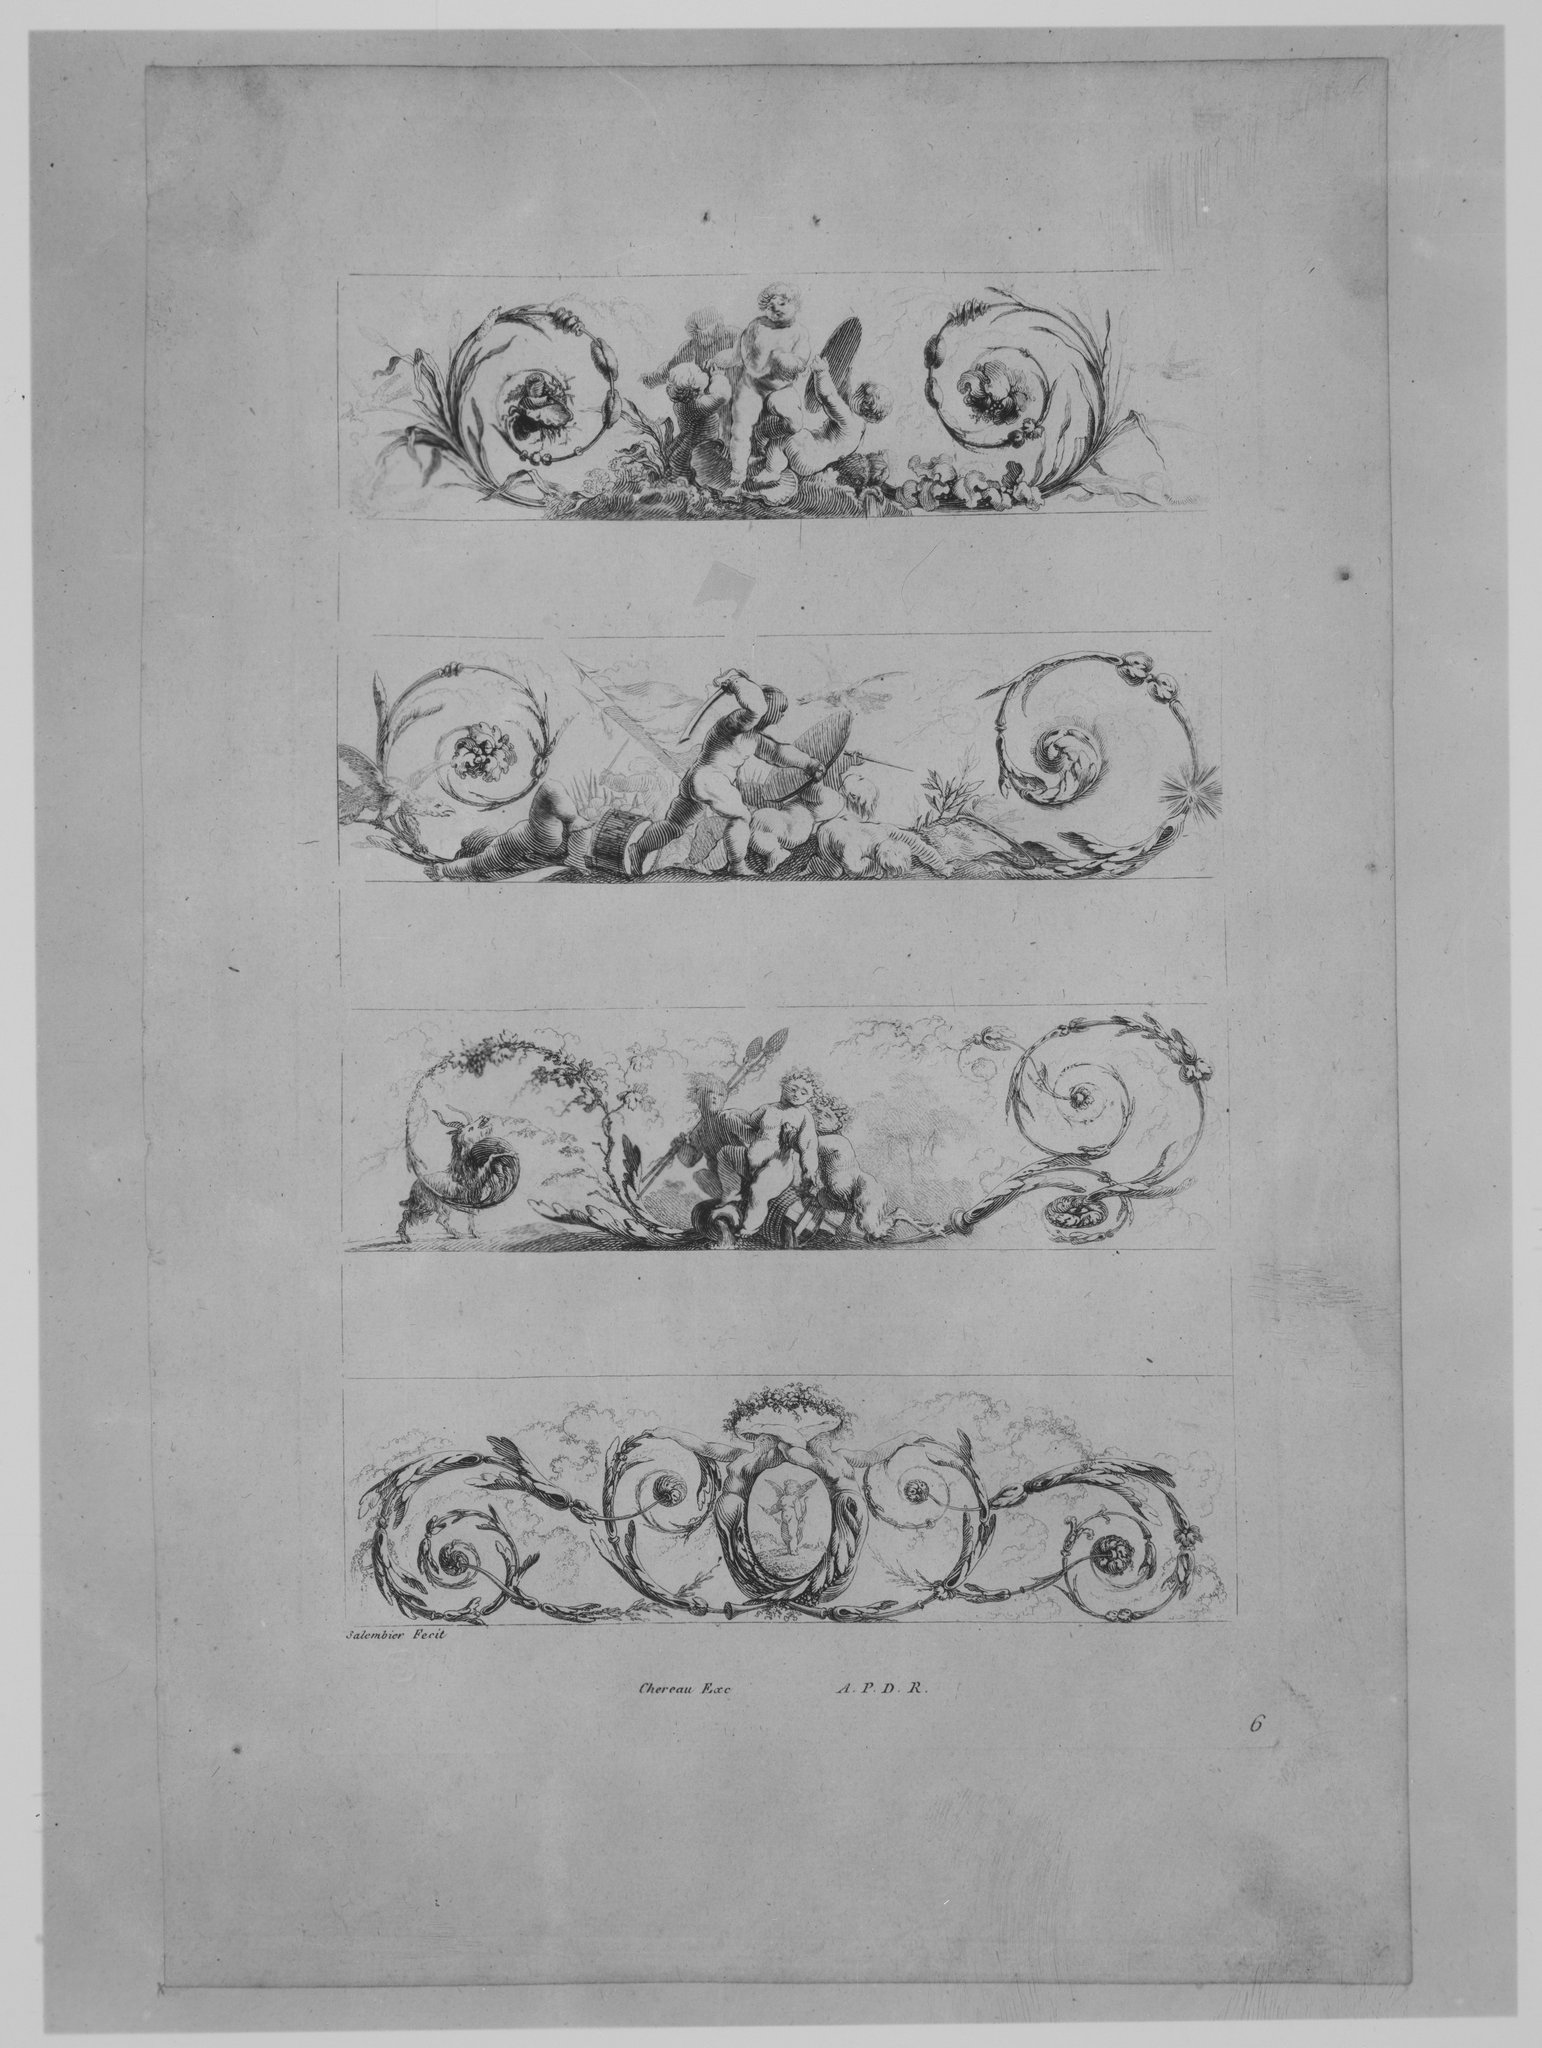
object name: book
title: 1e [-8e] Cahier d'Ornemens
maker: henri sallembier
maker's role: artist and engraver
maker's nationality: french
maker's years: 1753-1820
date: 1777-1778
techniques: engraving, etching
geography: france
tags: ornament,putti